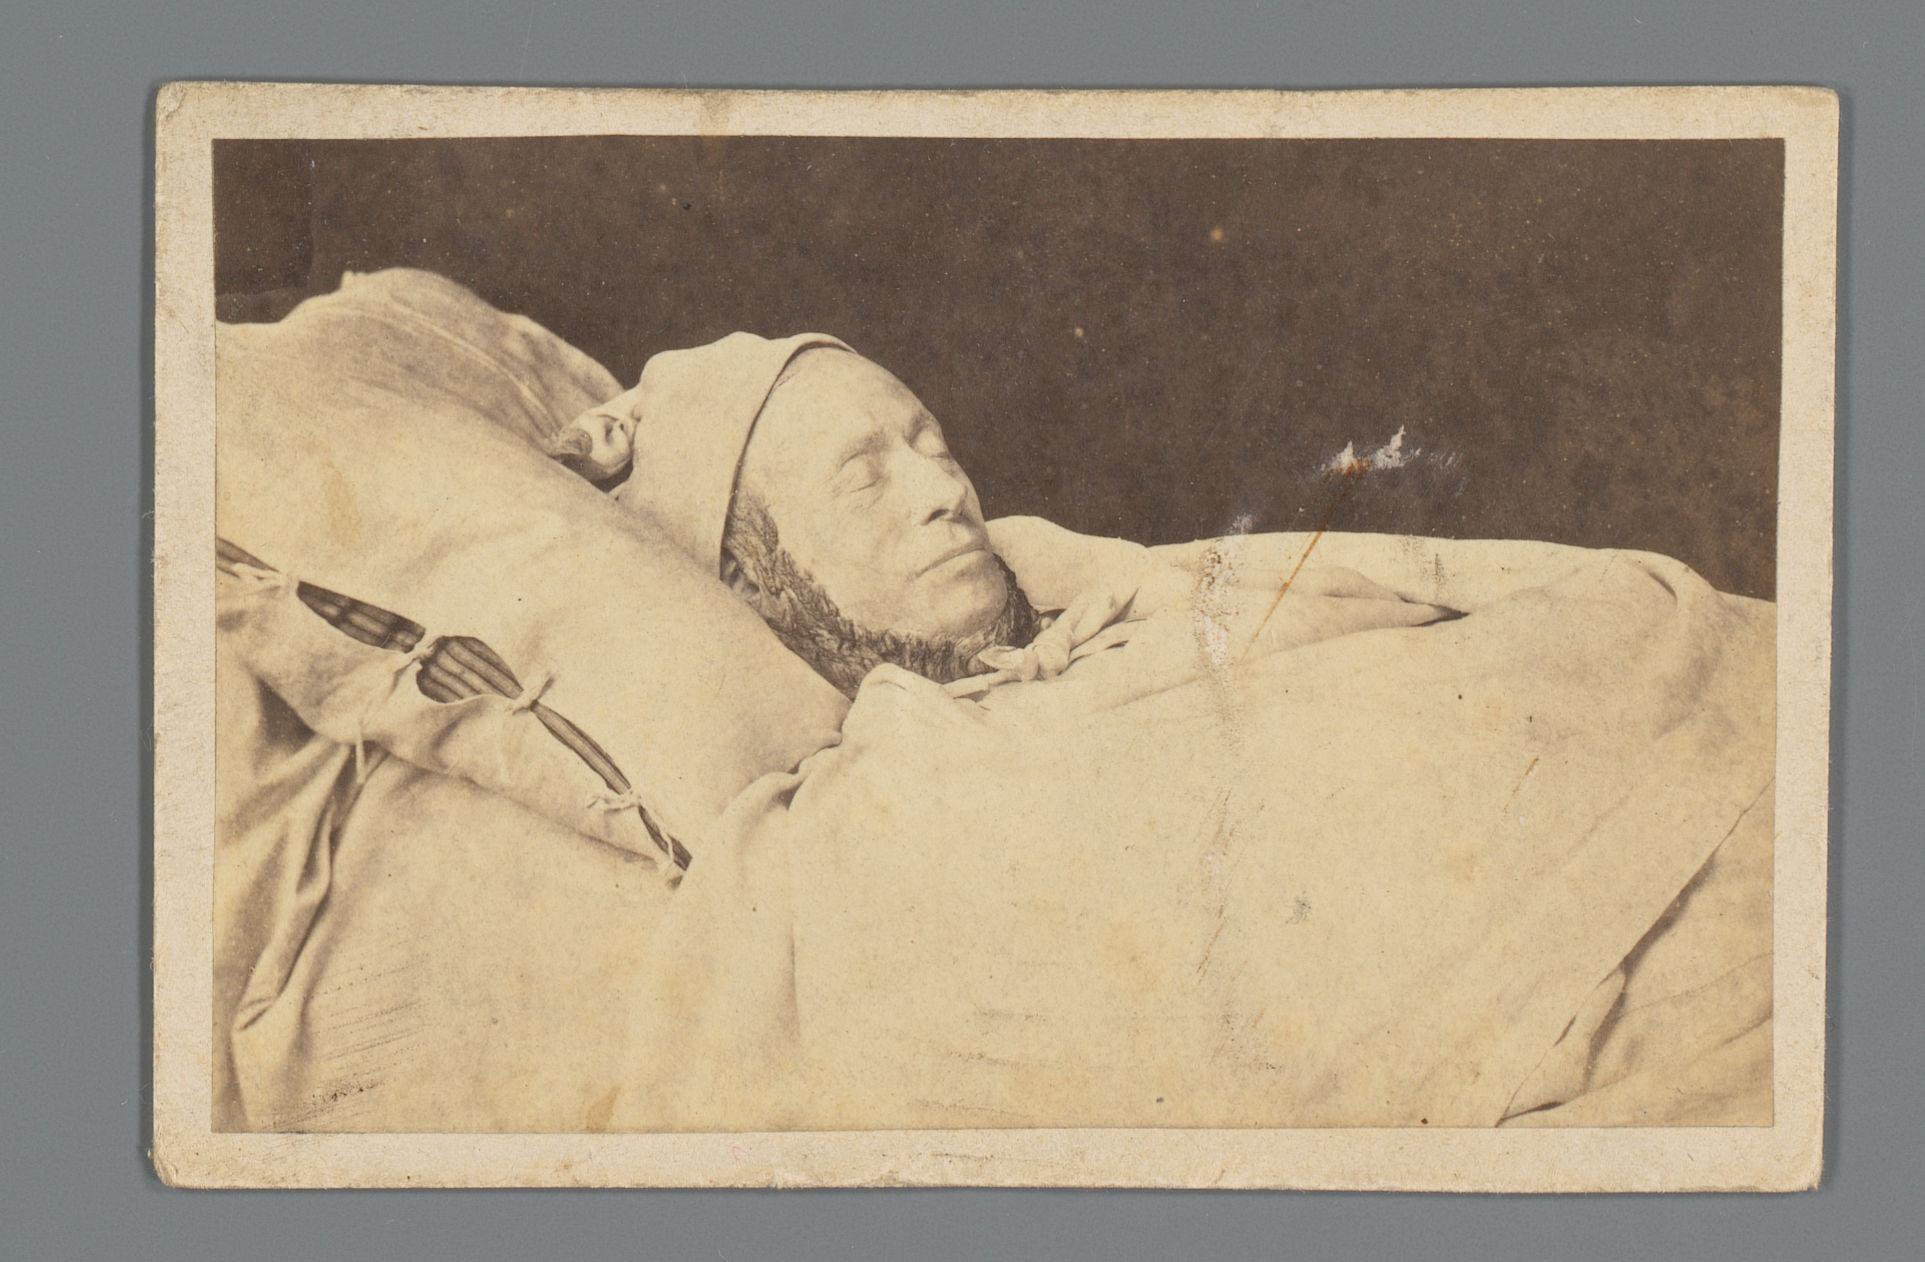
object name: photograph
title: Post-mortemportret van een onbekende man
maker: pierre vanhuysen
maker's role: fotograaf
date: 1863-1884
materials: cardboard, paper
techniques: albumen print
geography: leuven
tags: adult man, louvain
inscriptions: address: ‘rue de Paris, 22, à Louvain.’